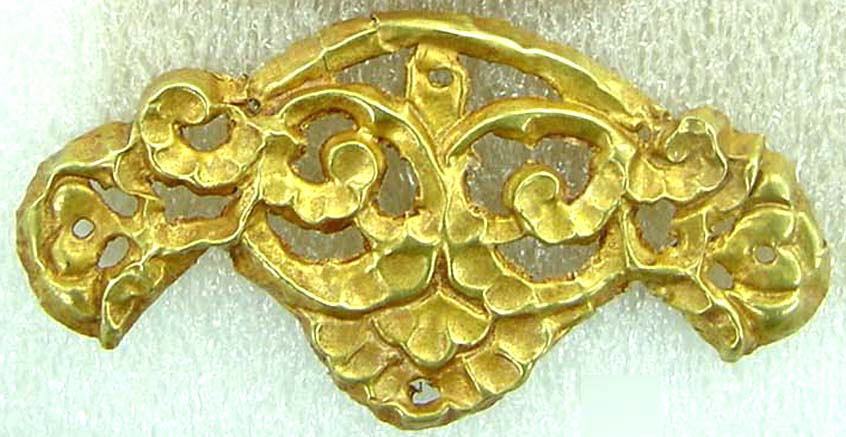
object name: plaque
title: Flower-Shaped Plaque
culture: northwest chinese or eastern central asian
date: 634-900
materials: gold